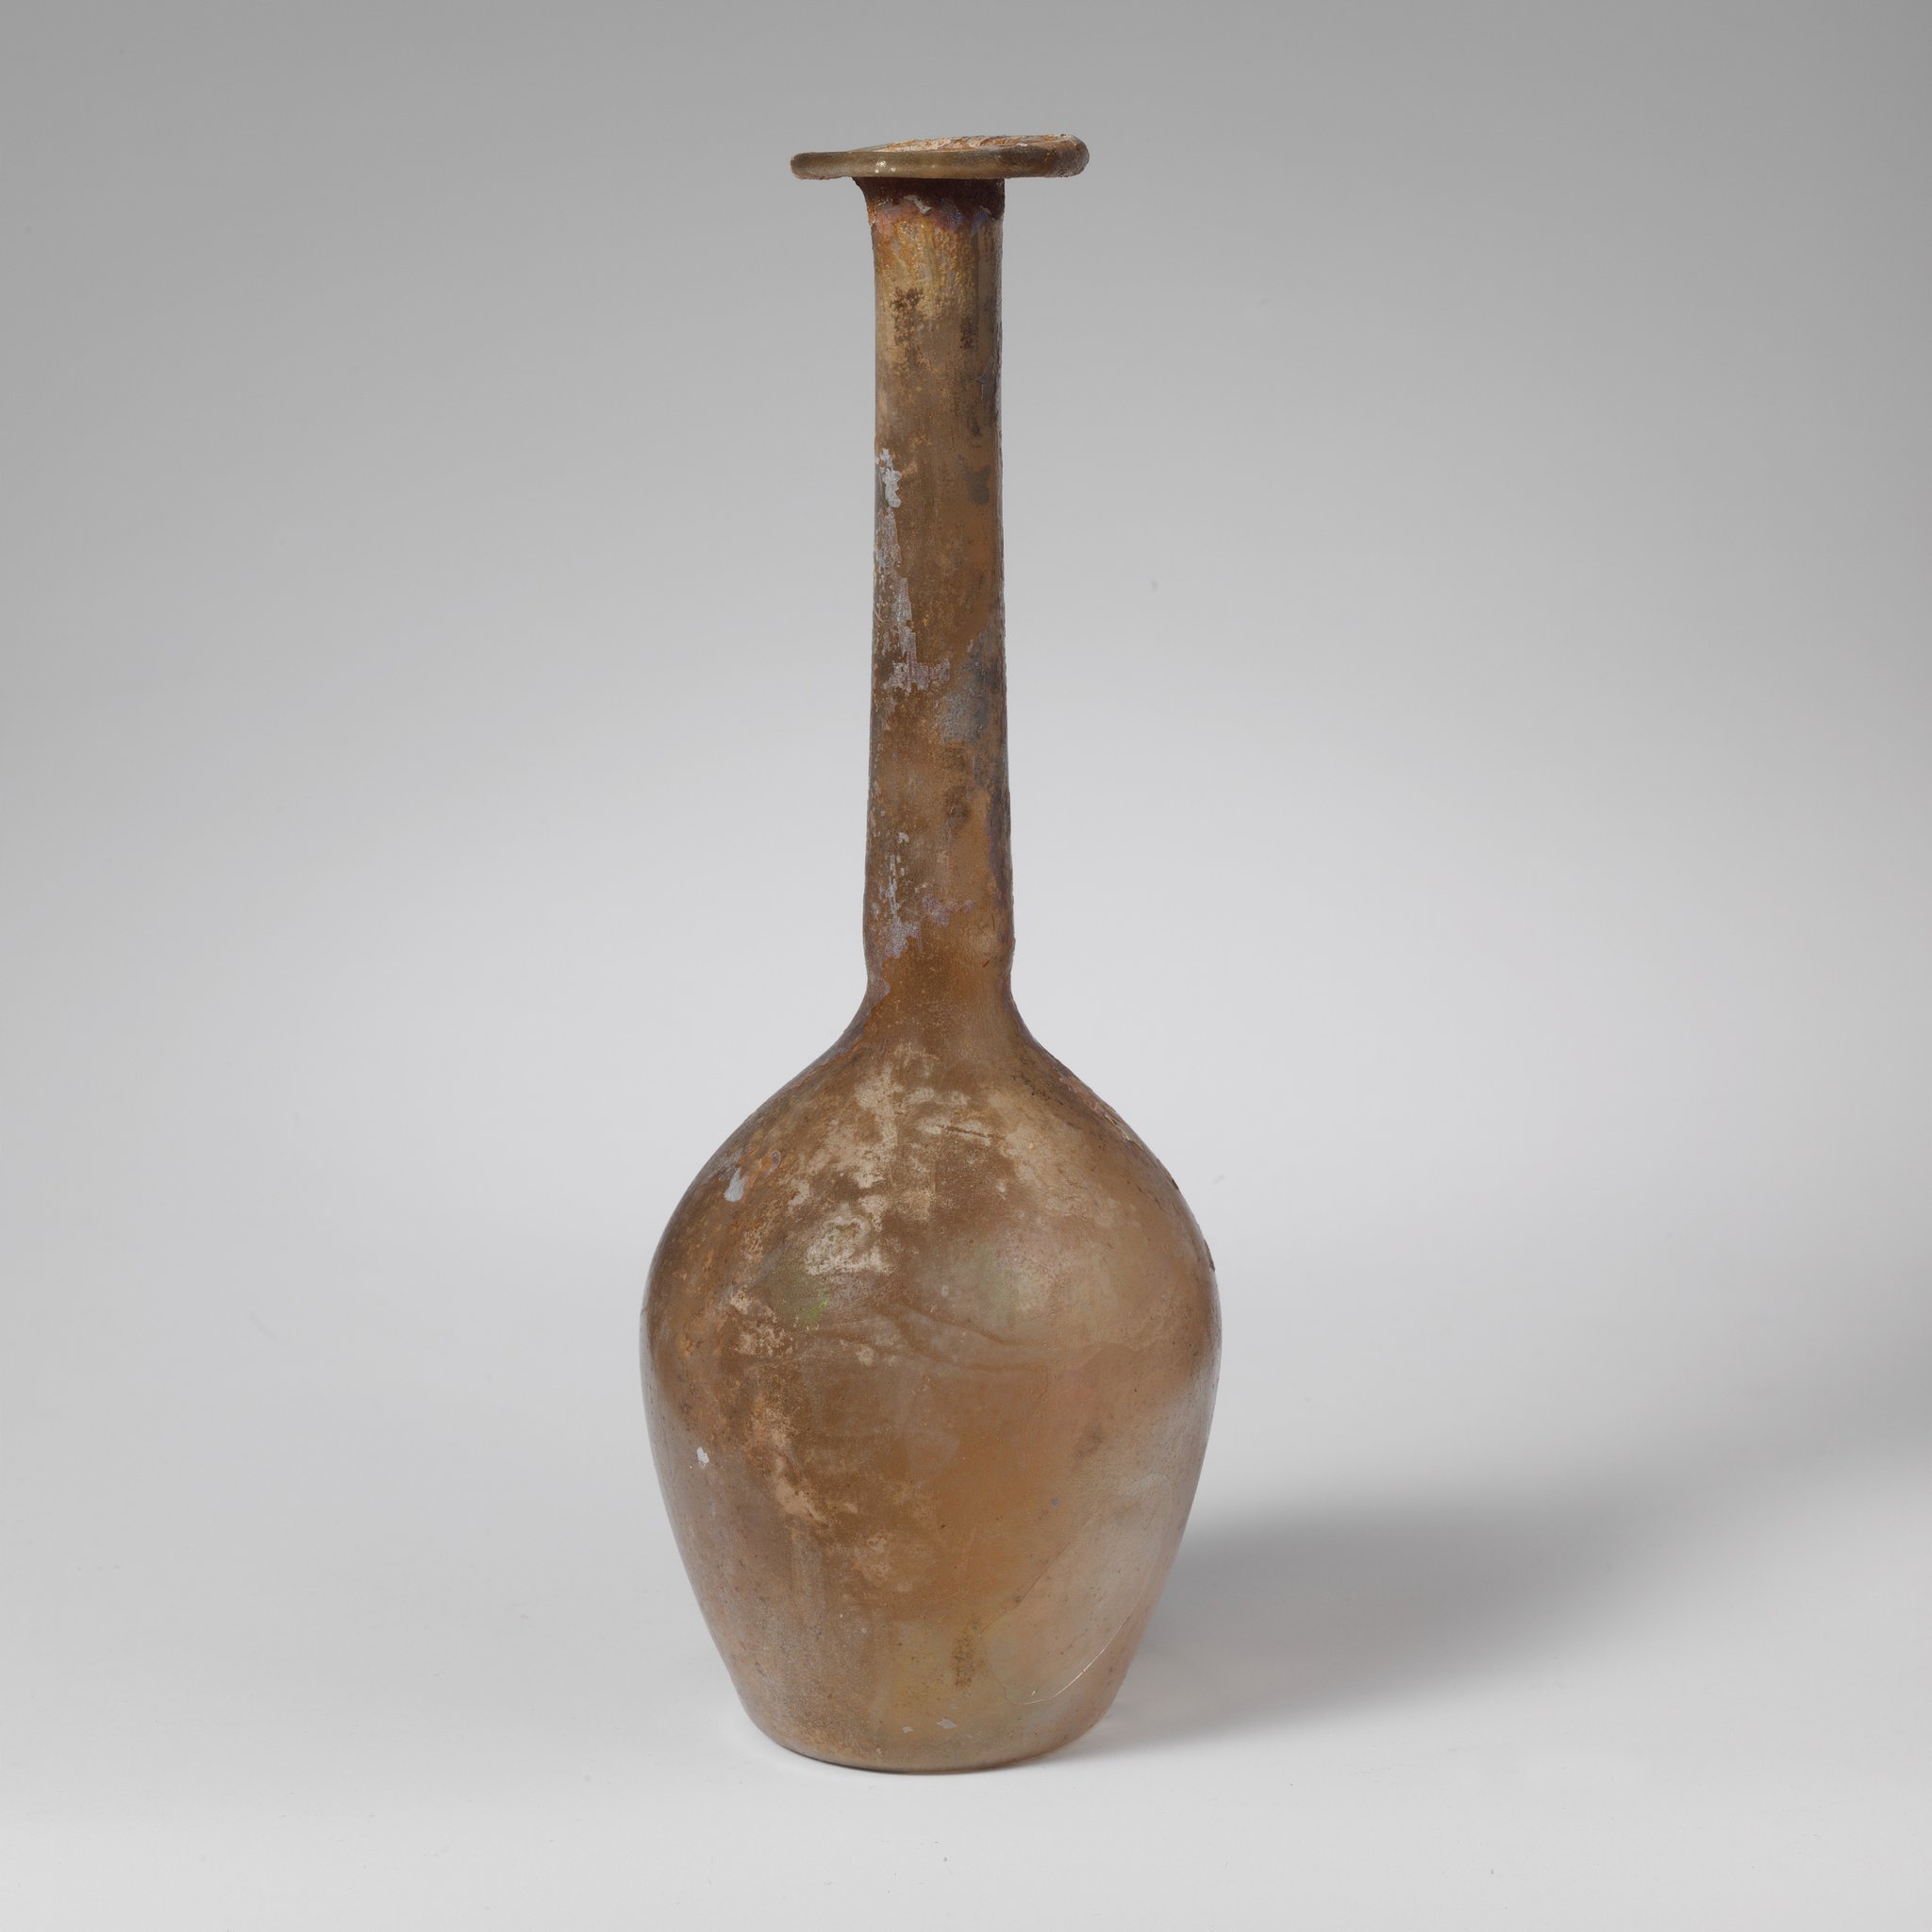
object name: perfume bottle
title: Glass perfume bottle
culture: roman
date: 101-300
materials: glass